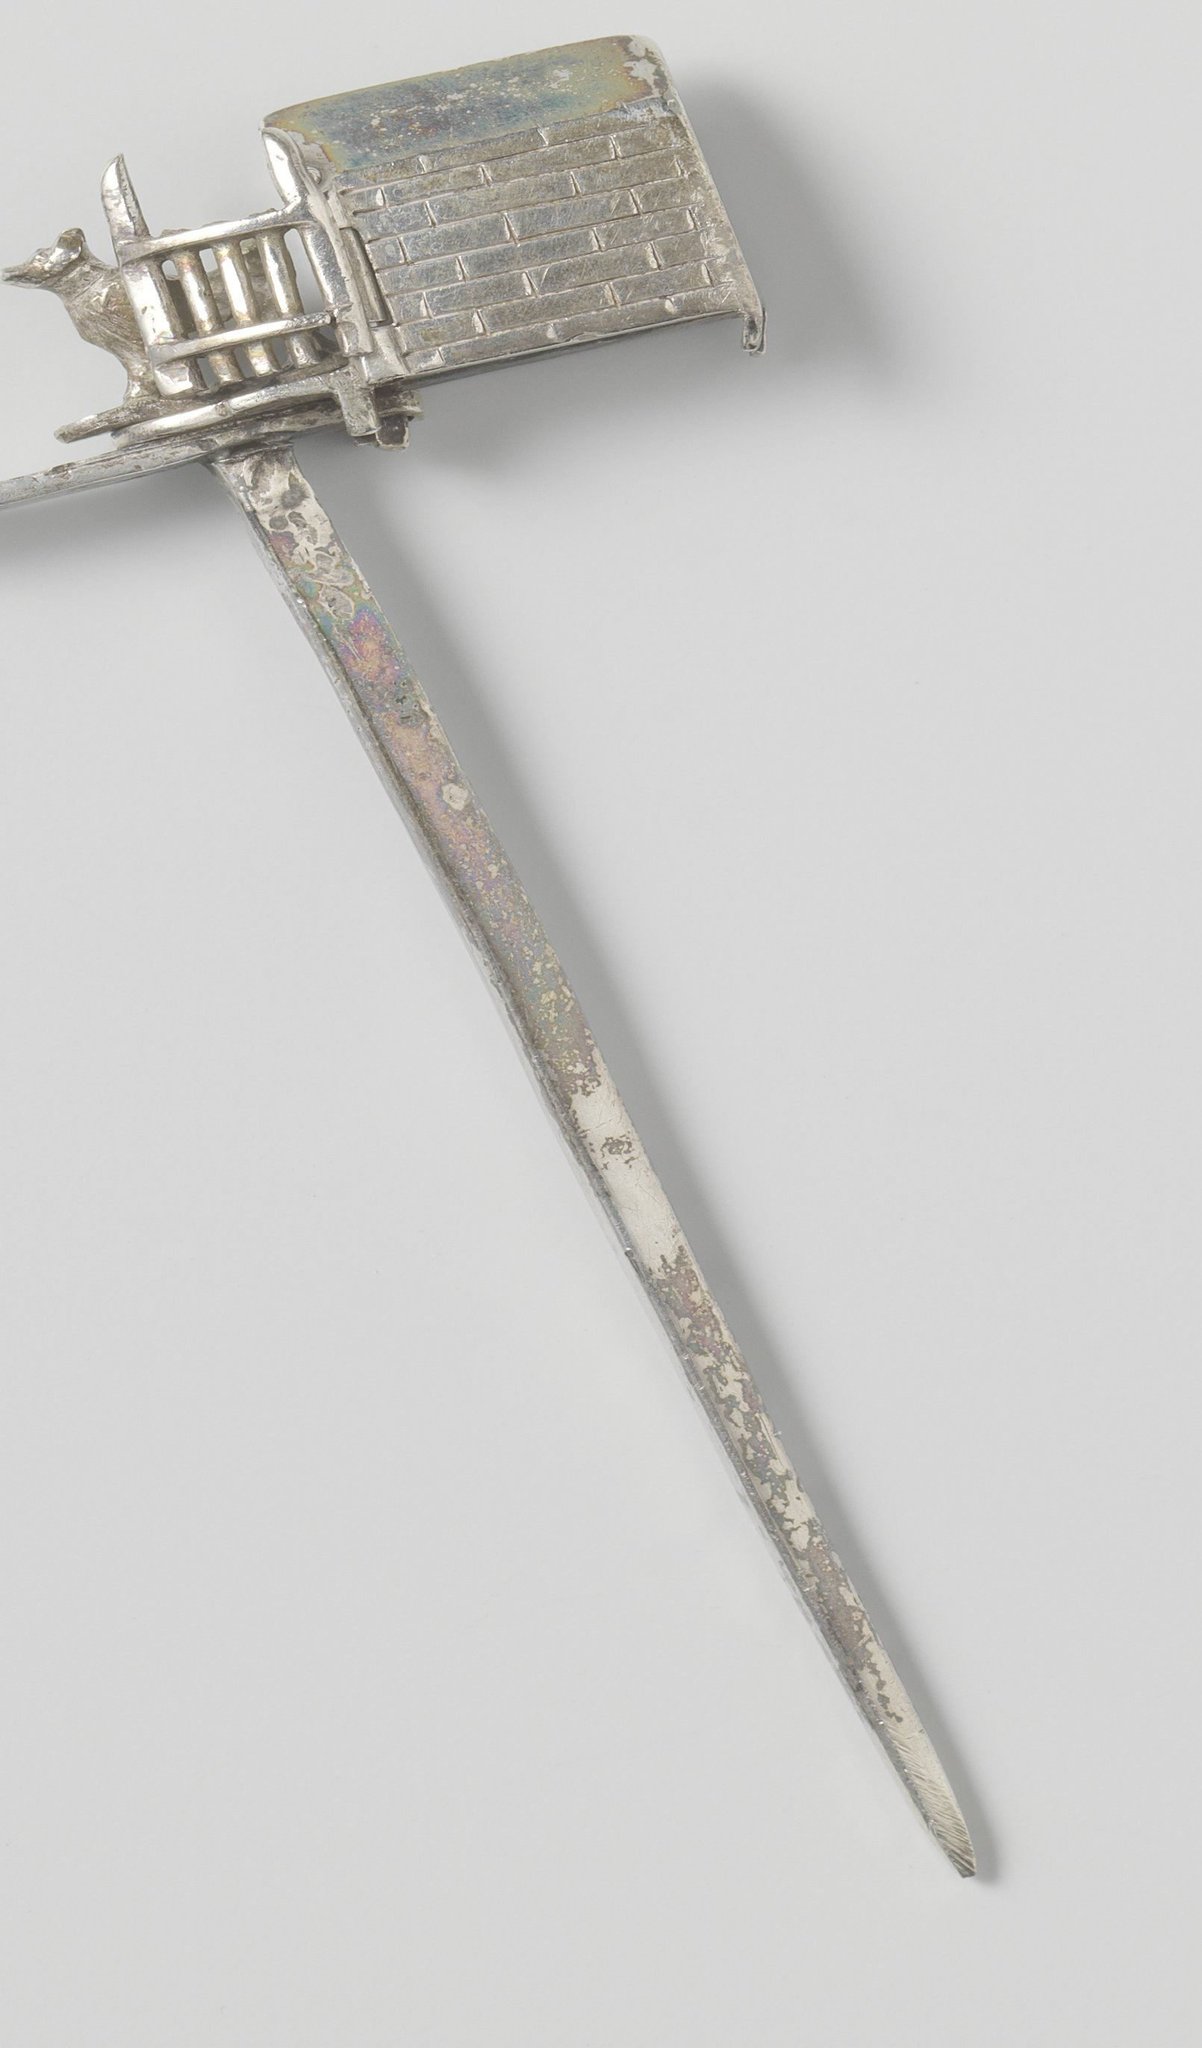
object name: pijpuithaler, pijpenschoonmaker, pijpenkoter, pijpenwroeter, pijpenrager, pijpenstoker, pijpenkrabber, pijpenpeuter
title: Patriotse pijpenpeuter met keeshond in hok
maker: Anonymous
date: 1787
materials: silver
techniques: casting, embroidery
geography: netherlands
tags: dog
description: Pipe cleaner with spitz dog.